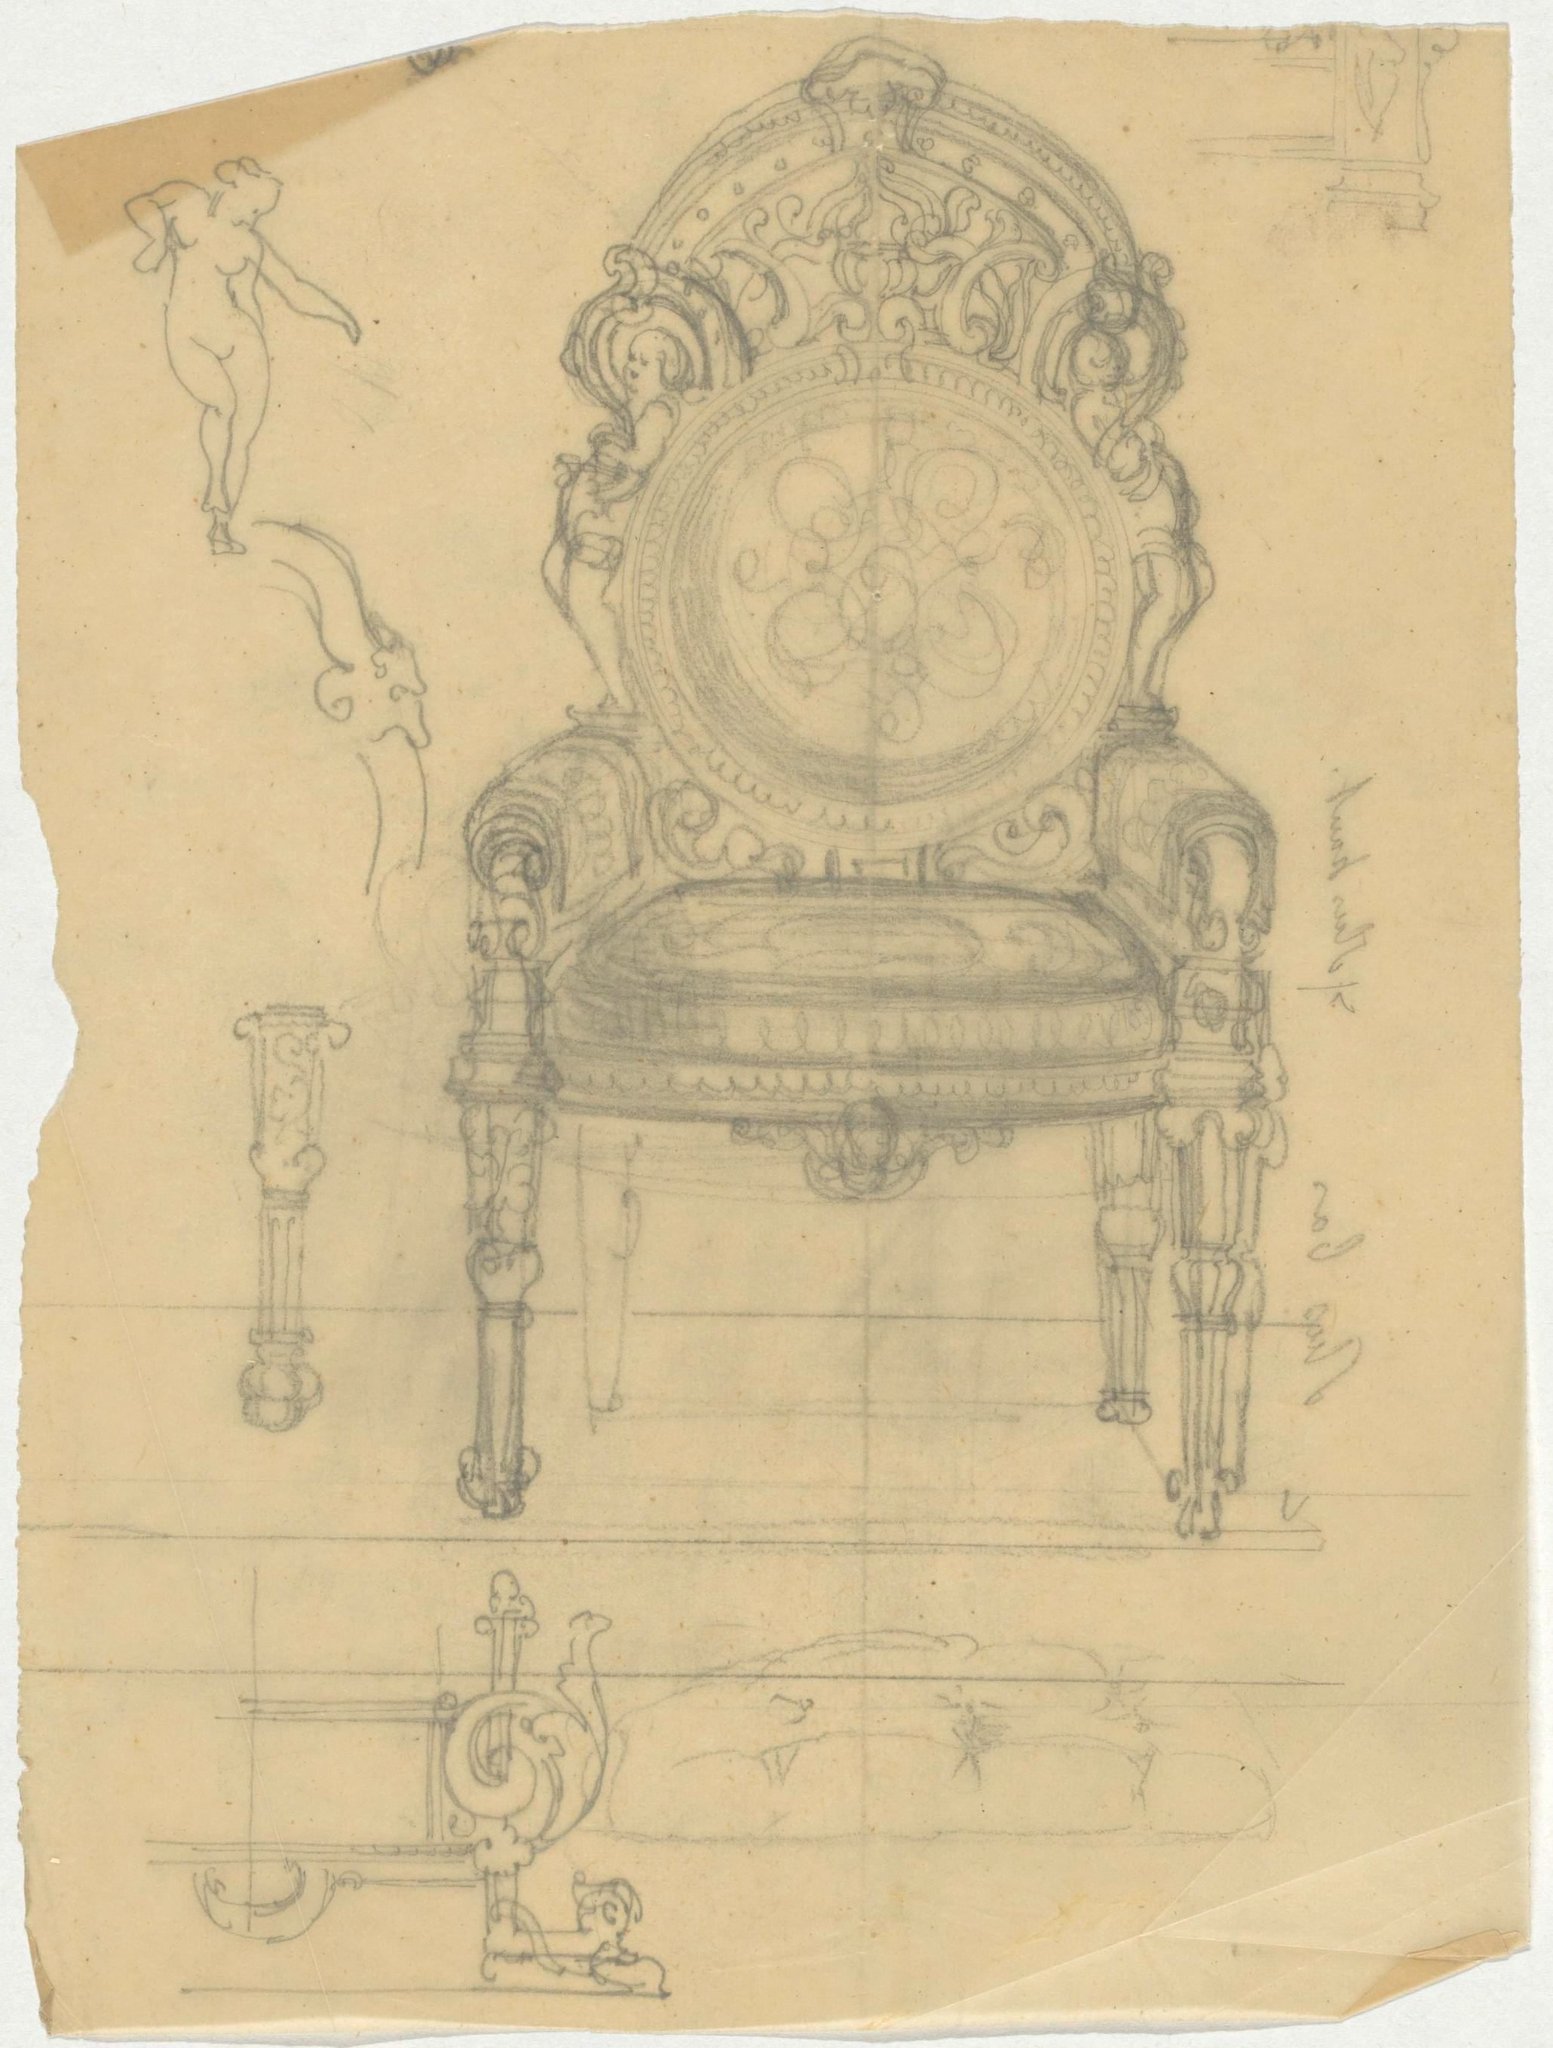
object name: design drawing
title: Armstoel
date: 1830-1850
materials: graphite, paper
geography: paris